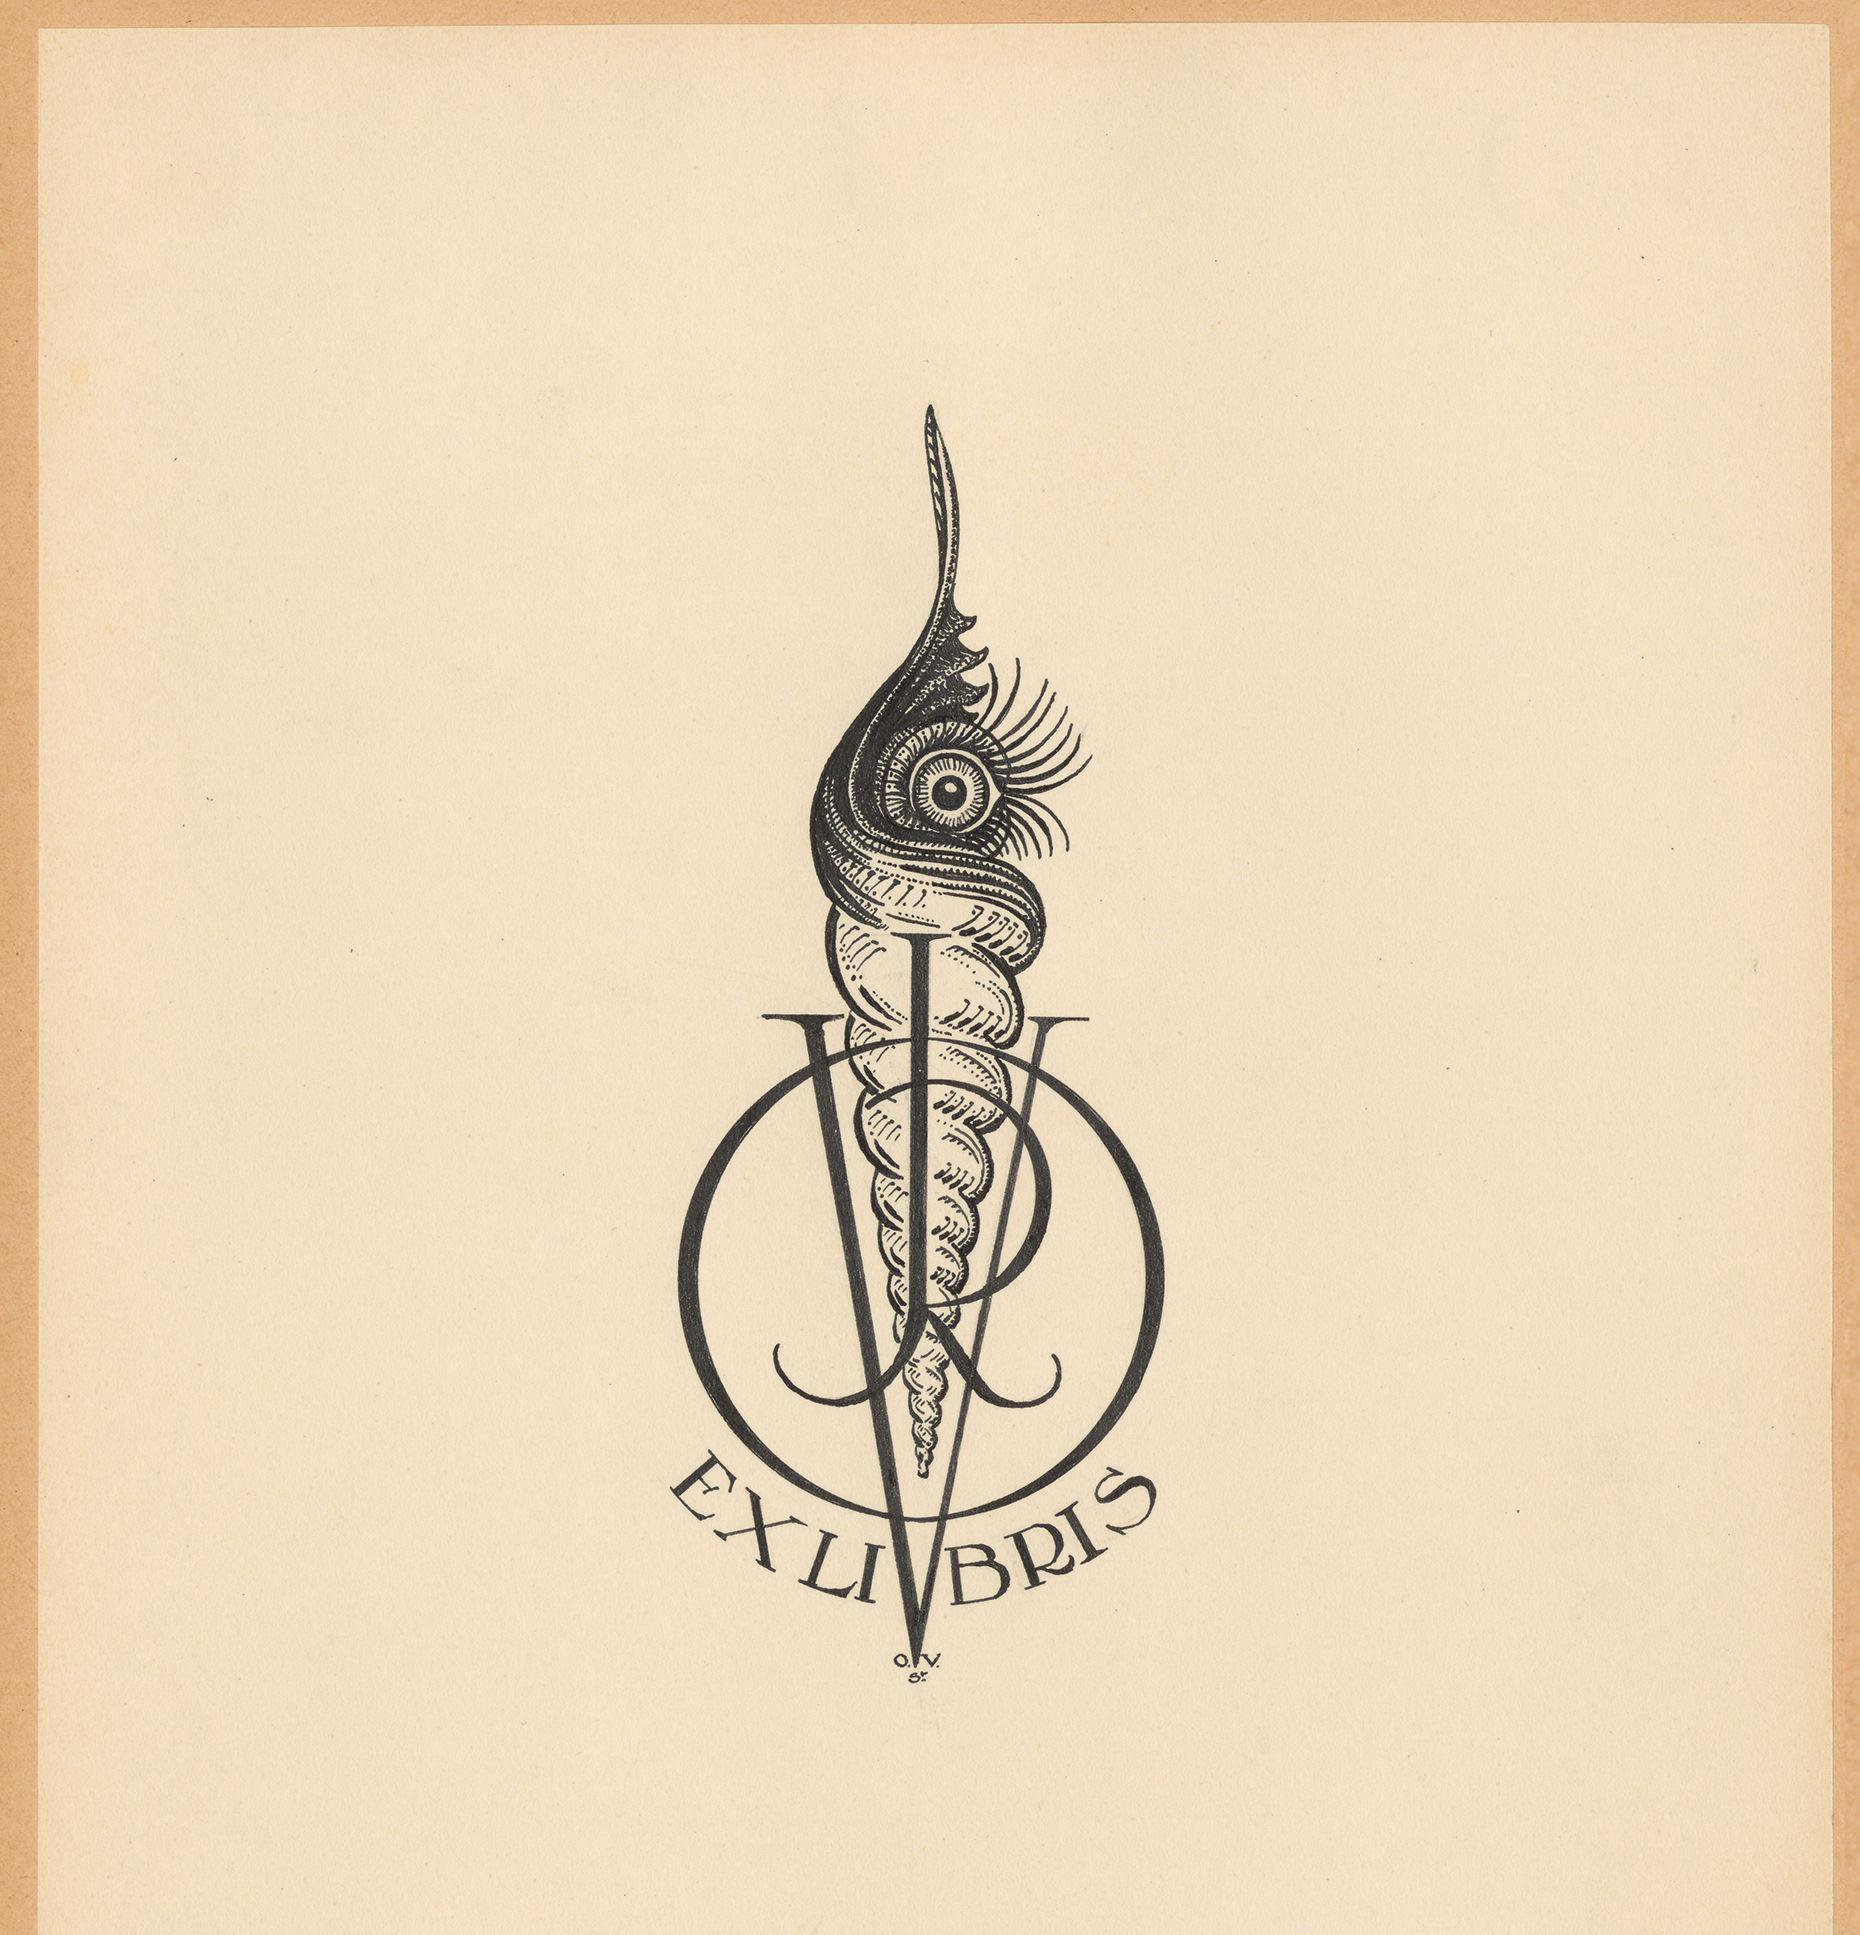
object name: design drawing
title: Ontwerptekening voor ex libris van Otto Verhagen jr.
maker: otto verhagen (i)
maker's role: draughtsman, print maker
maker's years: 1885-1951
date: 1942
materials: ink, paper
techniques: drawing, pen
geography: netherlands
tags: maarssen, painter, print maker, draughtsman, otto verhagen (ii), scallop, shell ~ ornament, eyes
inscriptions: inscription: ‘Penteekening-ontwerp. Ex libris voor O. Verhagen JR. voor Schelpenboeken/ Motief= schelp waaruit een menschenoog angstig de wereld bekijkt/ Niet uitgevoerd.’